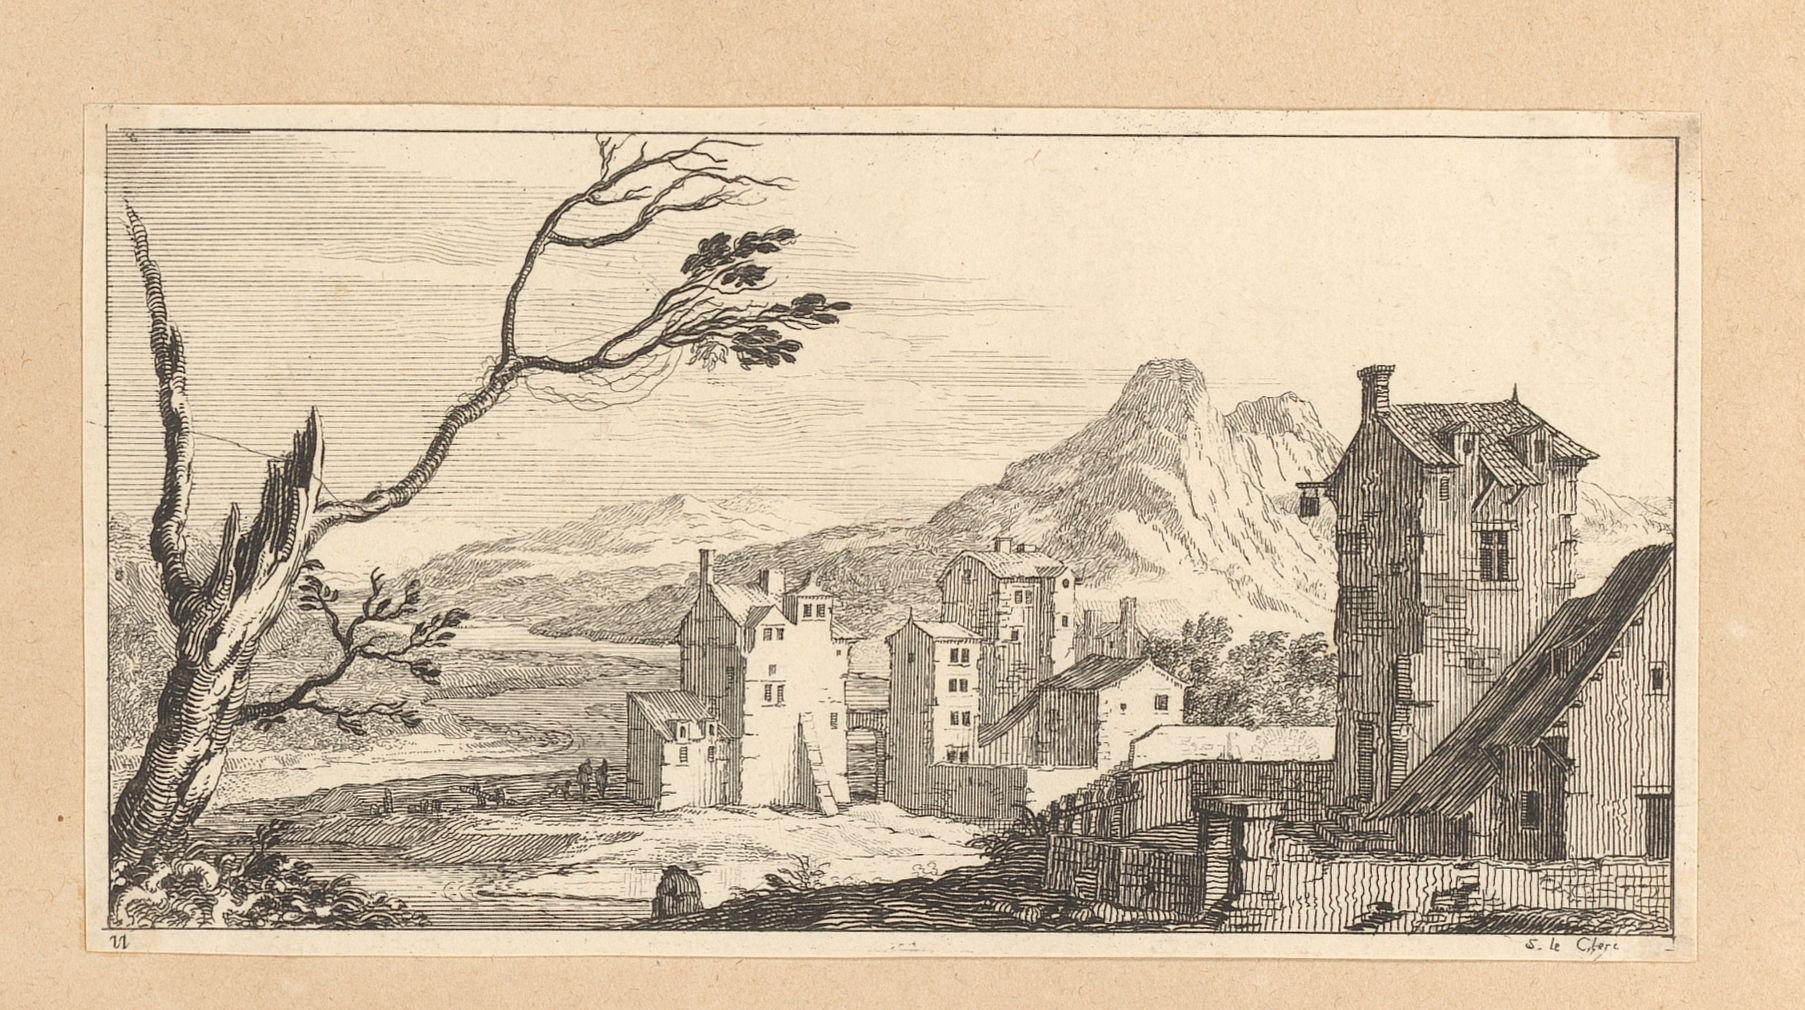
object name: print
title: Verschillende gebouwen en landschappen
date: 1693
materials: paper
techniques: etching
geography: paris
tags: city-view, and landscape with man-made constructions, mountains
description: Maakt deel uit van een twaalfdelige serie met landschappen en gezichten op verschillende gebouwen. Een eerste editie werd uitgegeven door Nicolas Langlois in 1693 en een tweede in 1784 door Lamy.